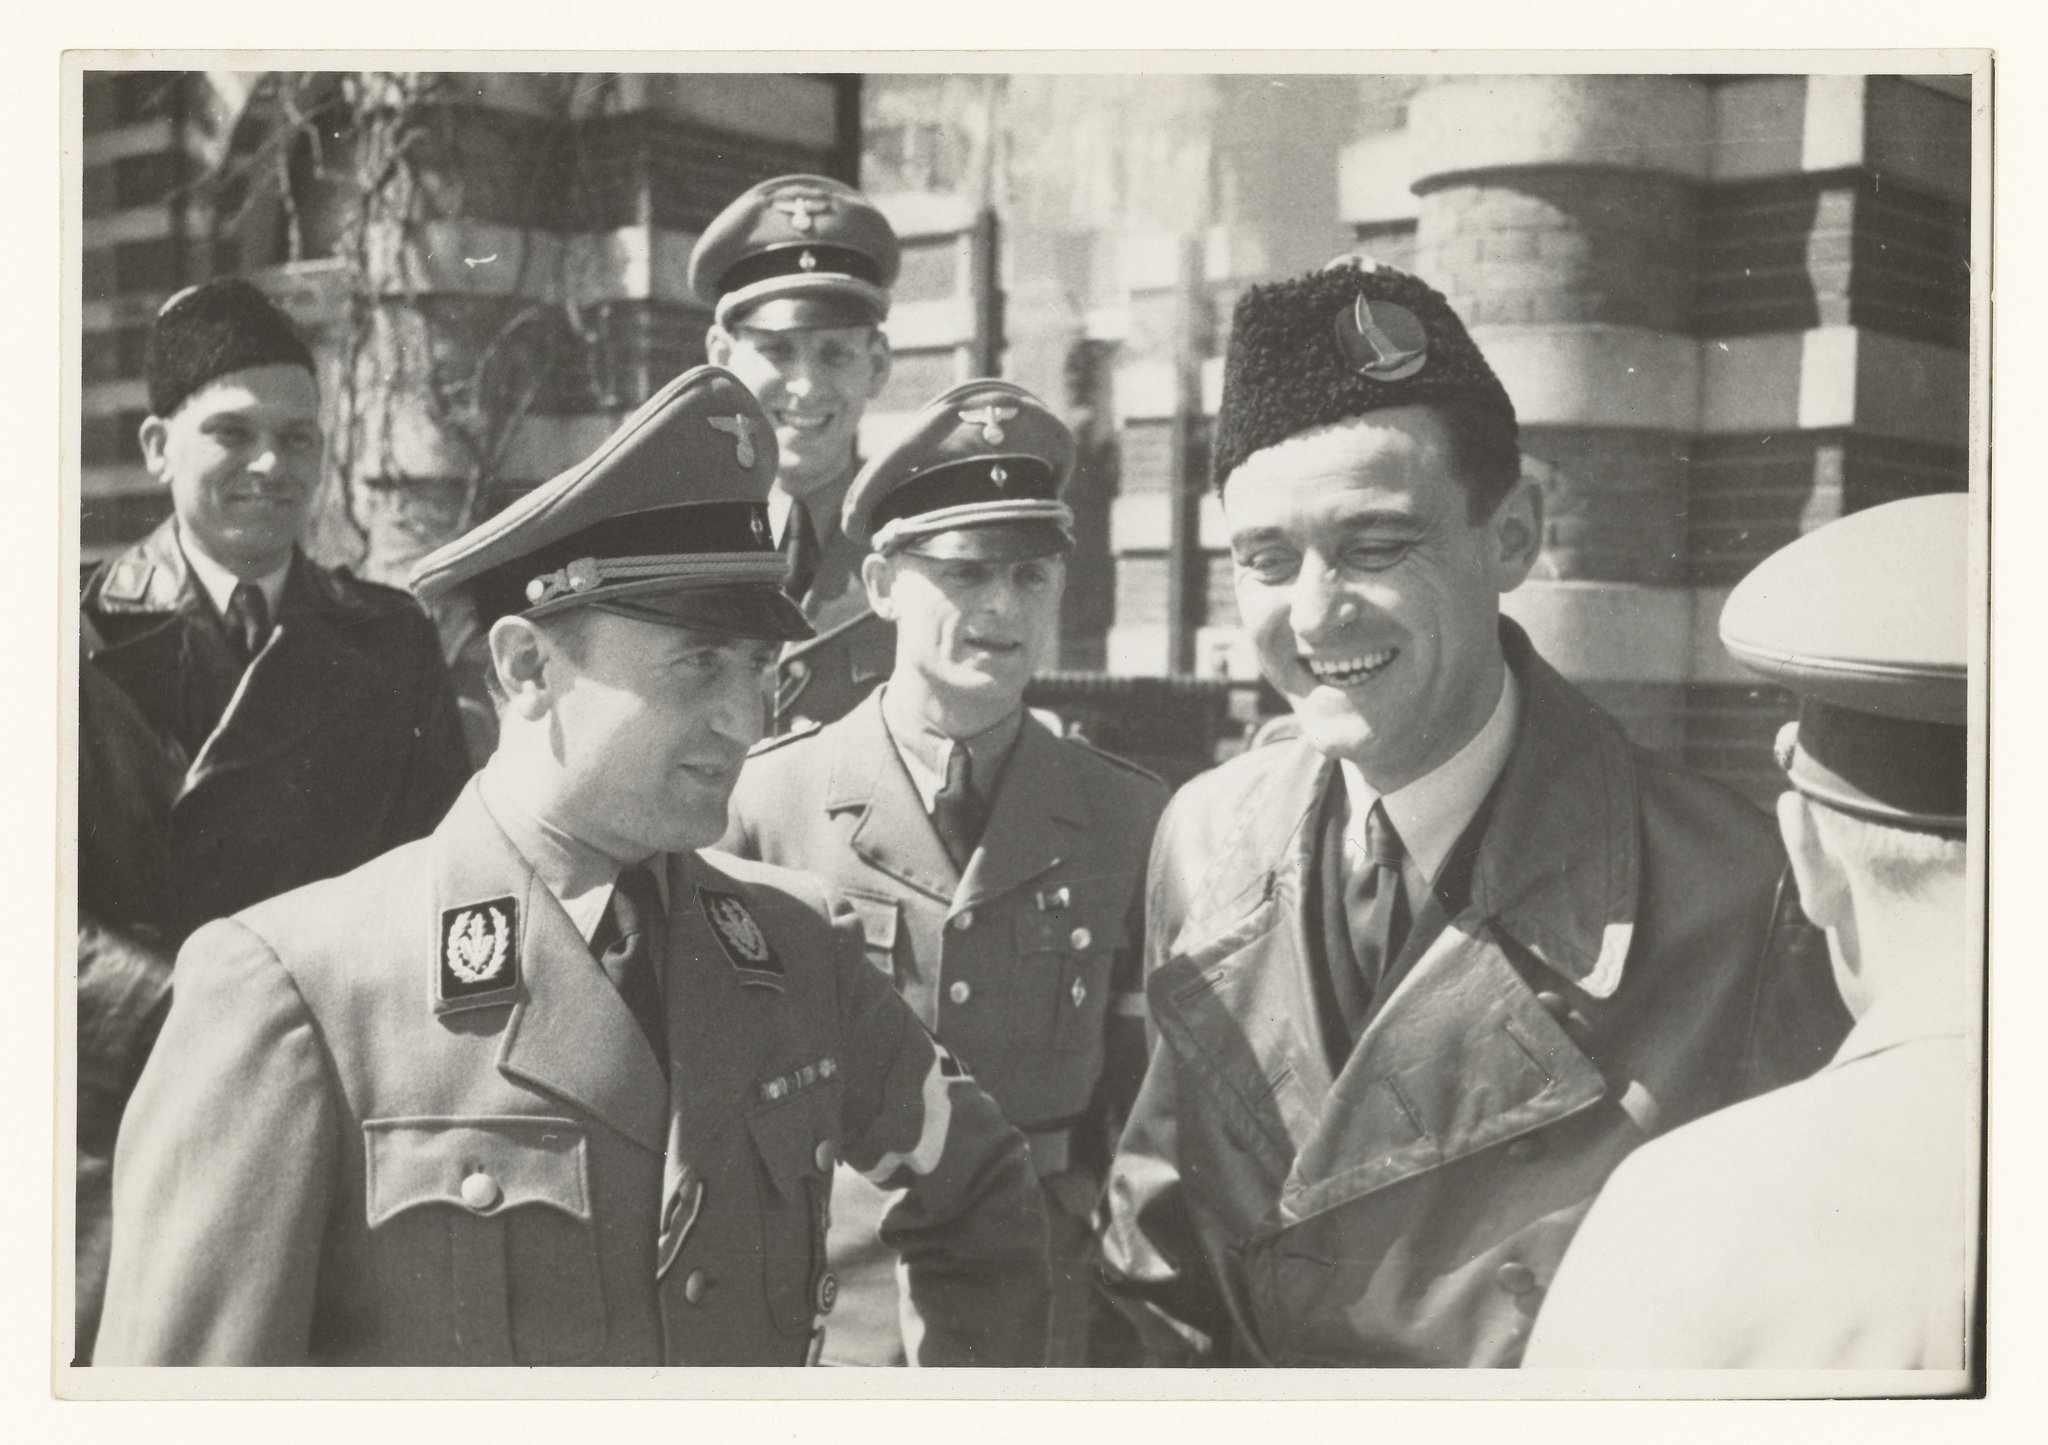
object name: photograph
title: NSB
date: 1942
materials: photographic support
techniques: gelatin silver print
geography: the hague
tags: political meeting, propaganda meeting, the hague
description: Arthur Axmann, Reichsjugendführer, en Van Geelkerken, leider ven de Jeugdstorm in gesprek met drie hooggeplaatste Duitsers. Links nog een lid van de Jeugdstorm. Van Geelkerken draagt een leren jas en op zijn hoofd de "karpoets" van de Jeugdstorm.